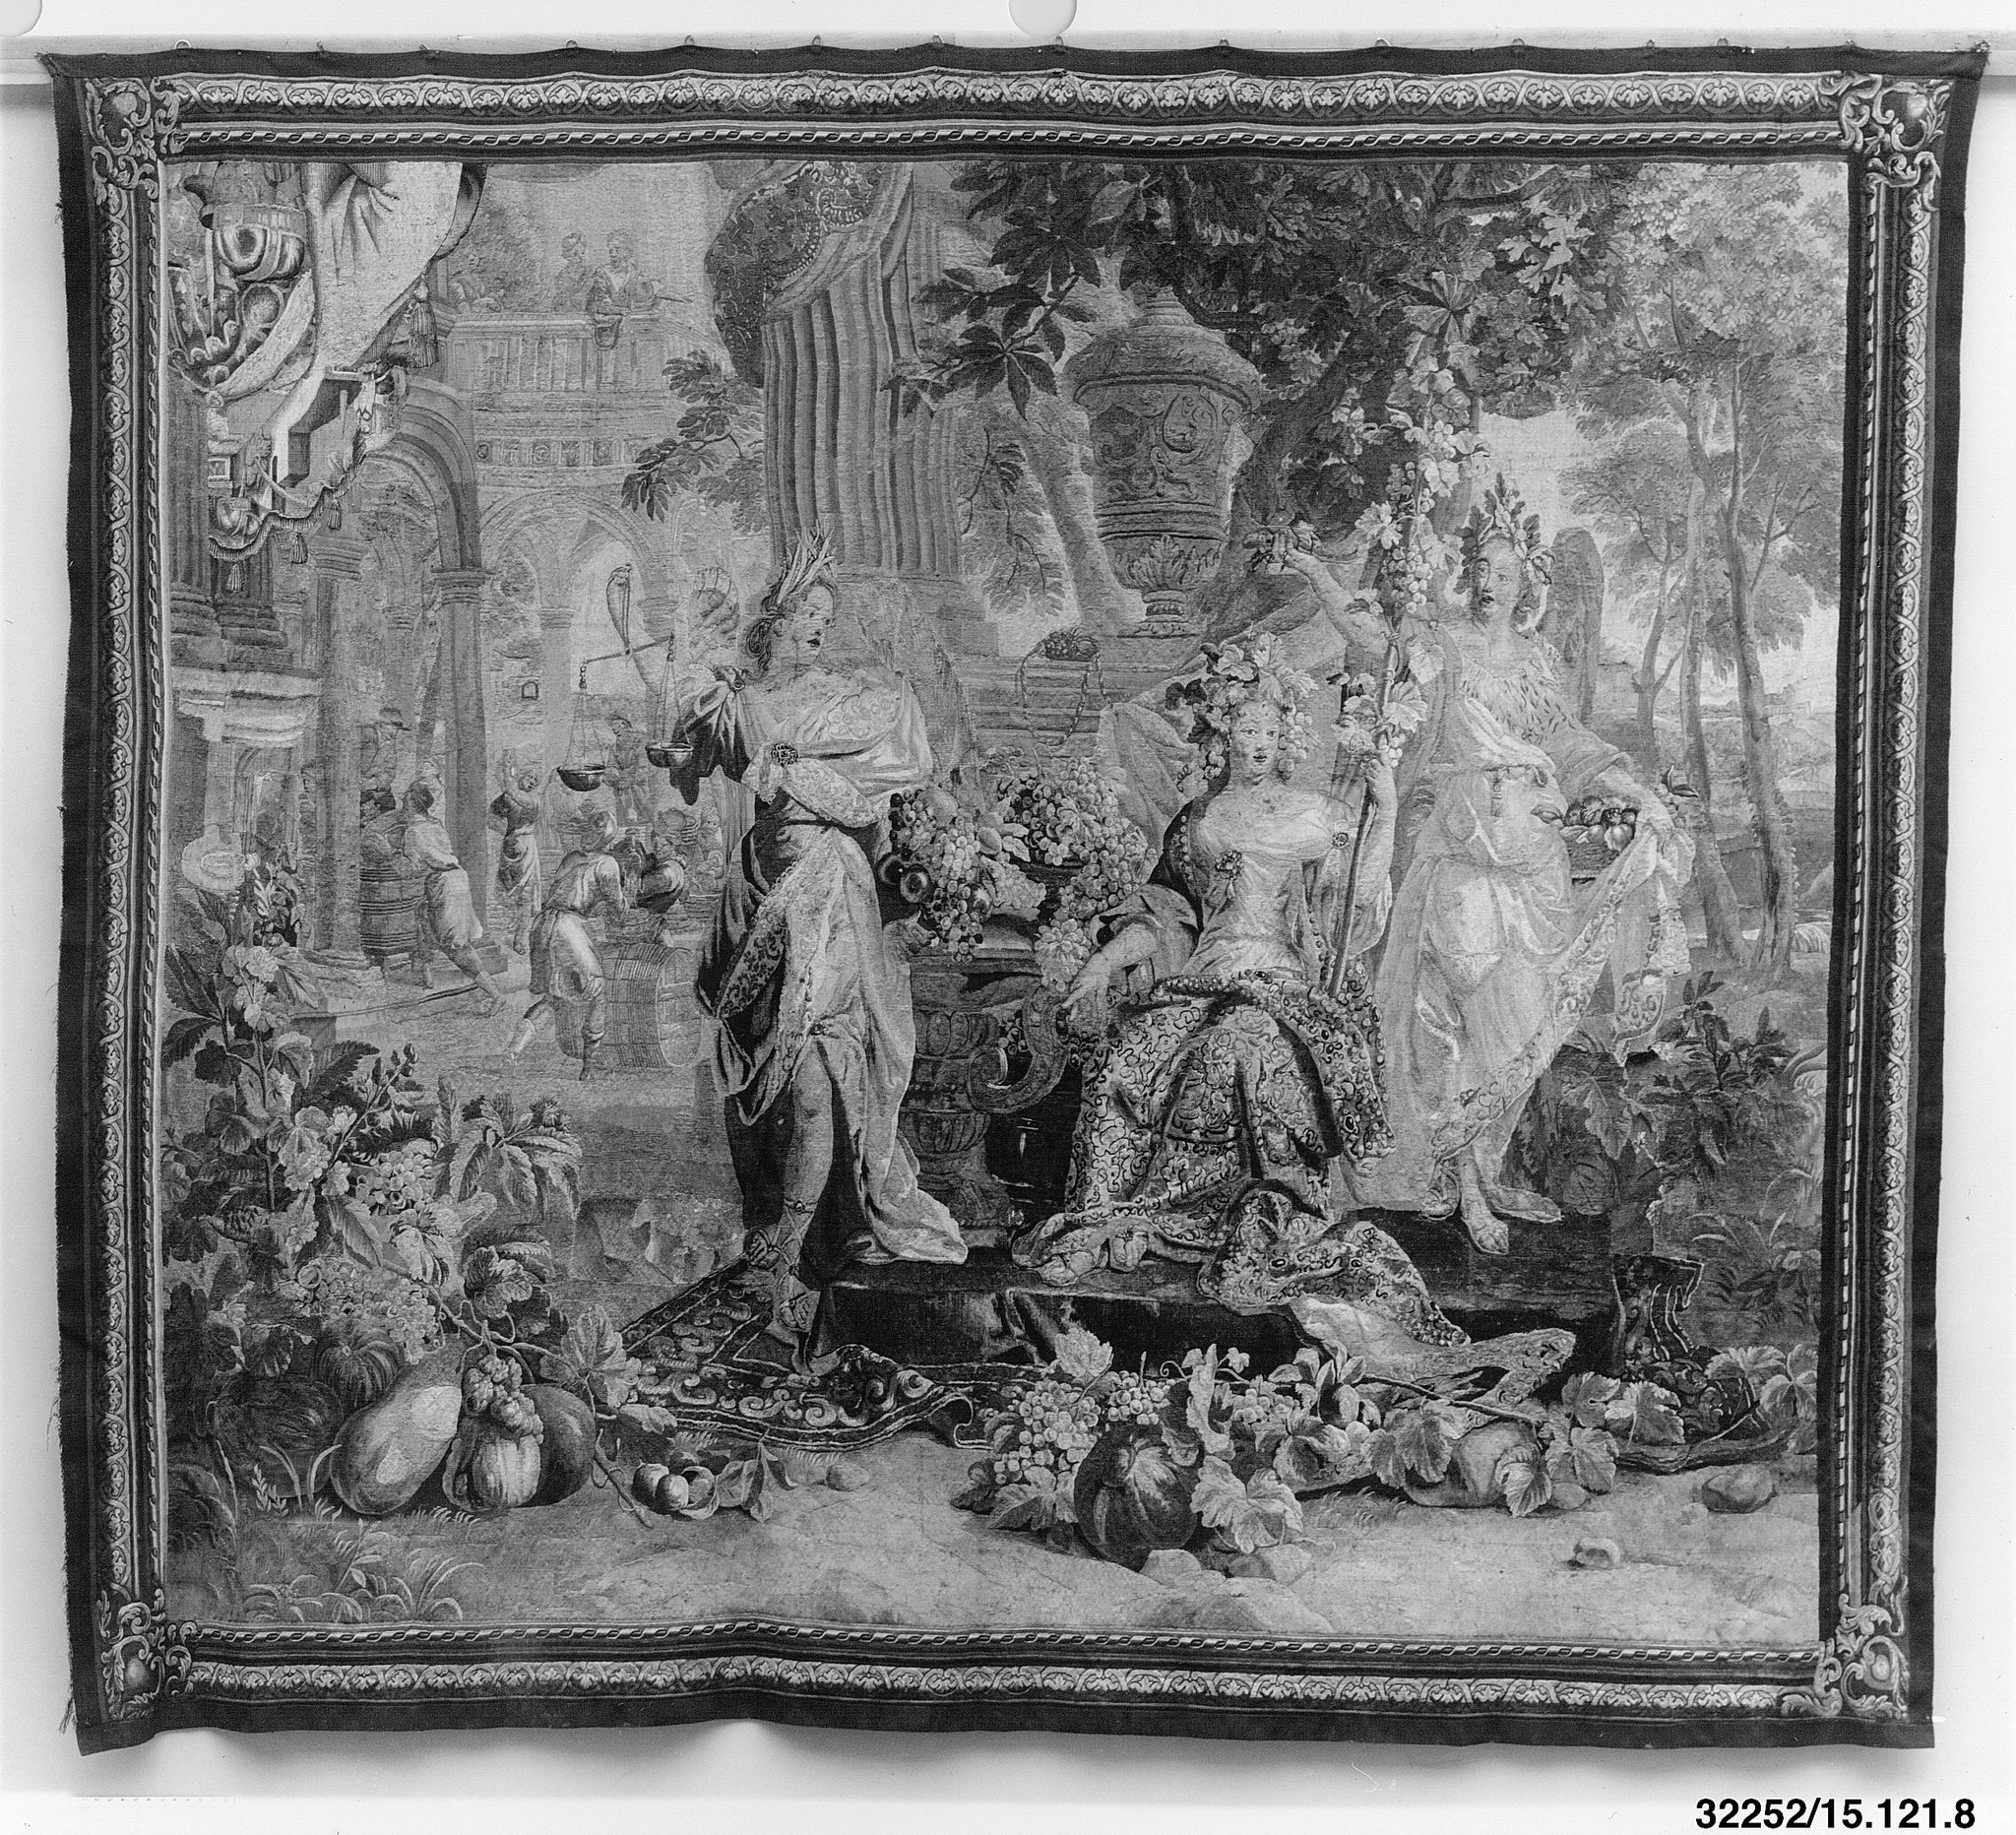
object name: tapestry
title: Autumn from a set of the Four Seasons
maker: lodewijk van schoor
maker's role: designer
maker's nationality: flemish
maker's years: 1666-1702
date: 1690-1720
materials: silk, wool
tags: buildings,fruit,men,women,autumn